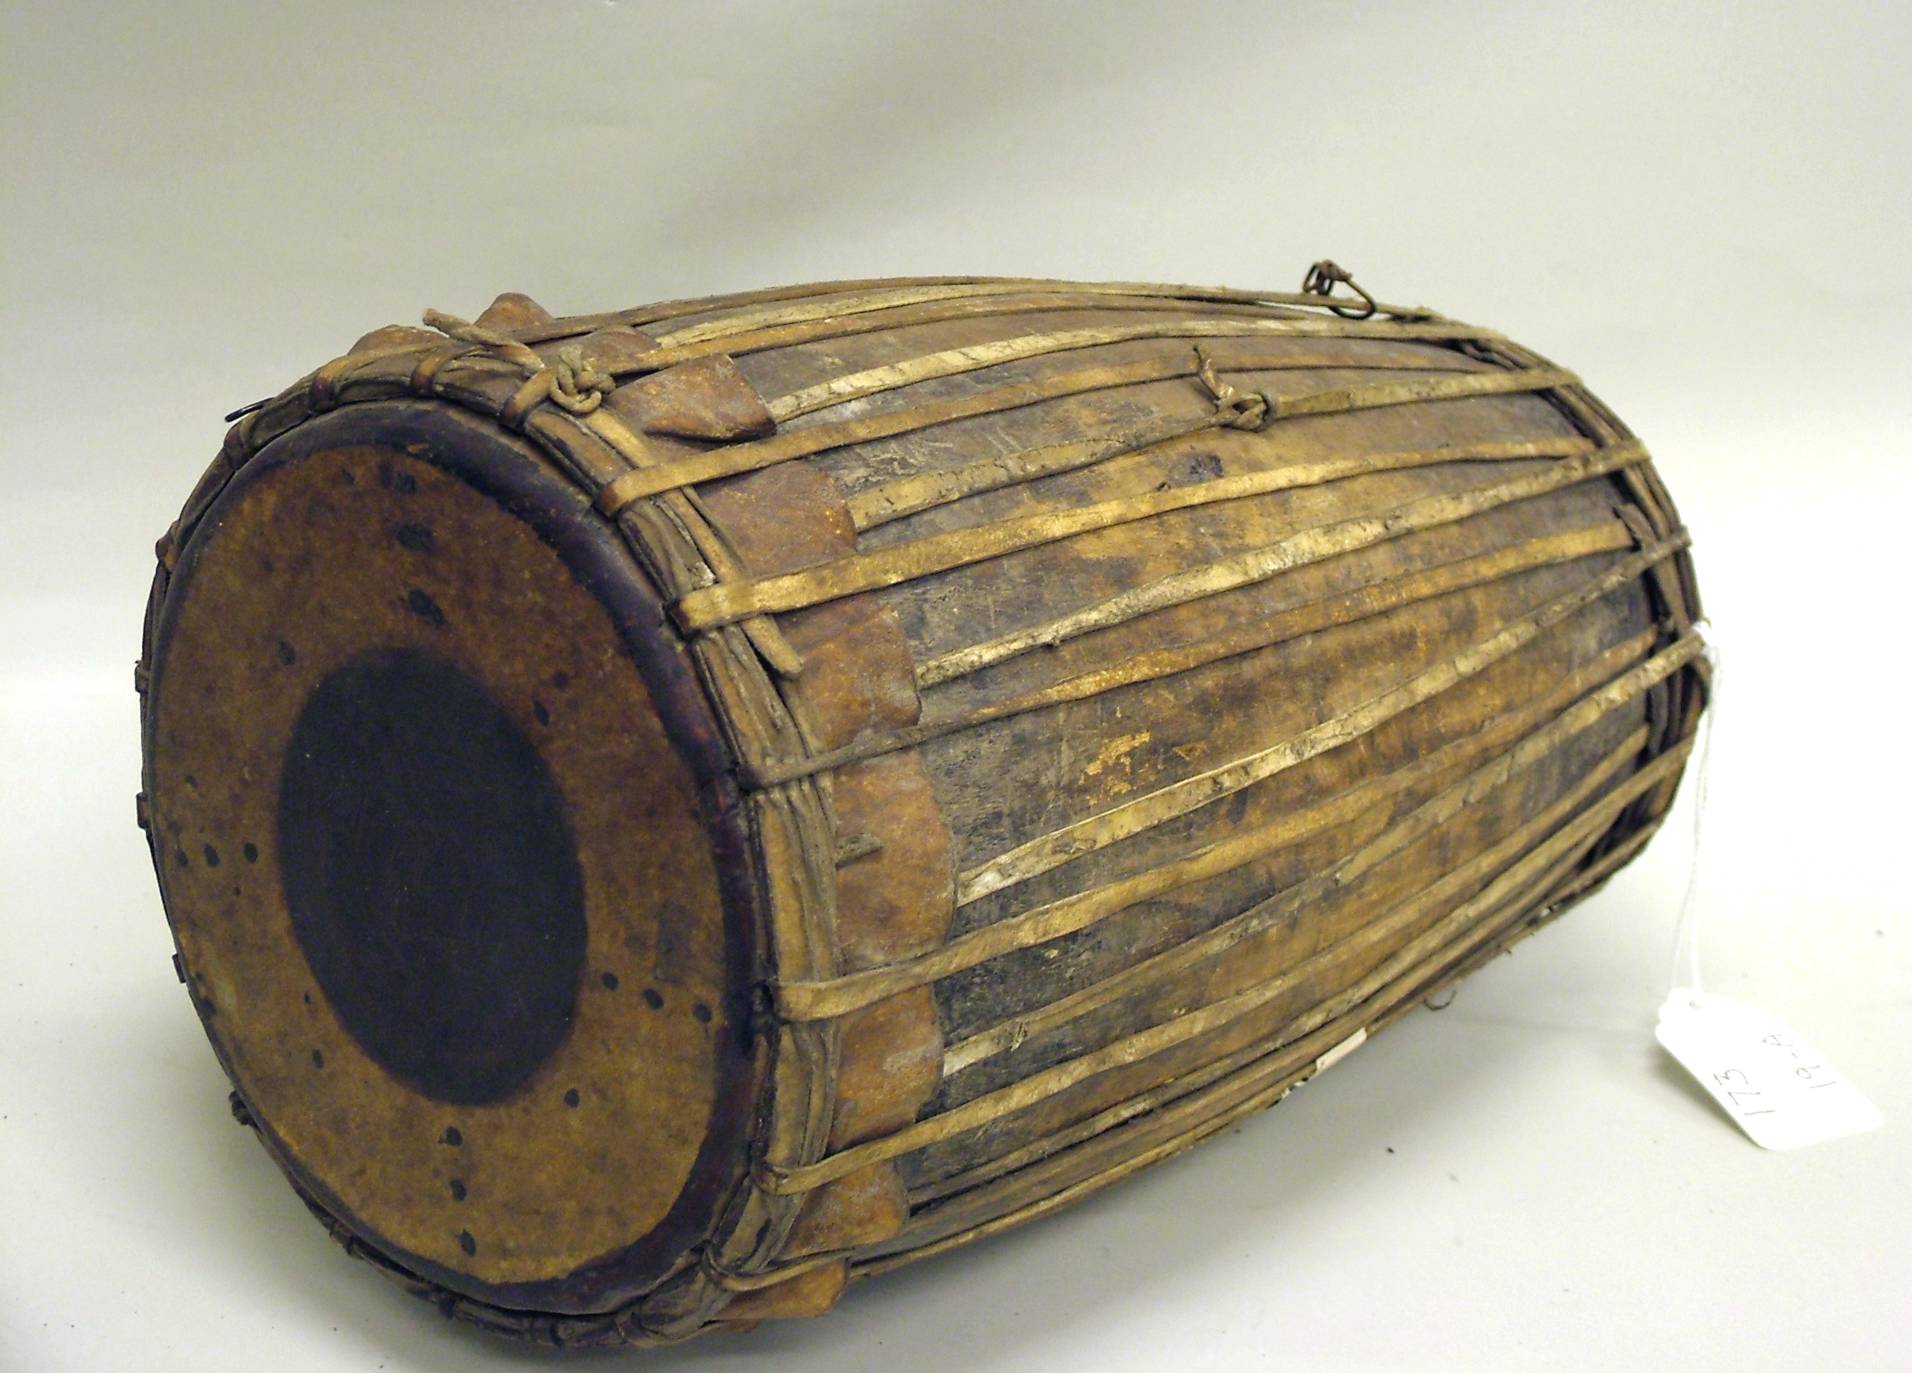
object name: dhola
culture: indian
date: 1801-1900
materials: skin, wood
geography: india